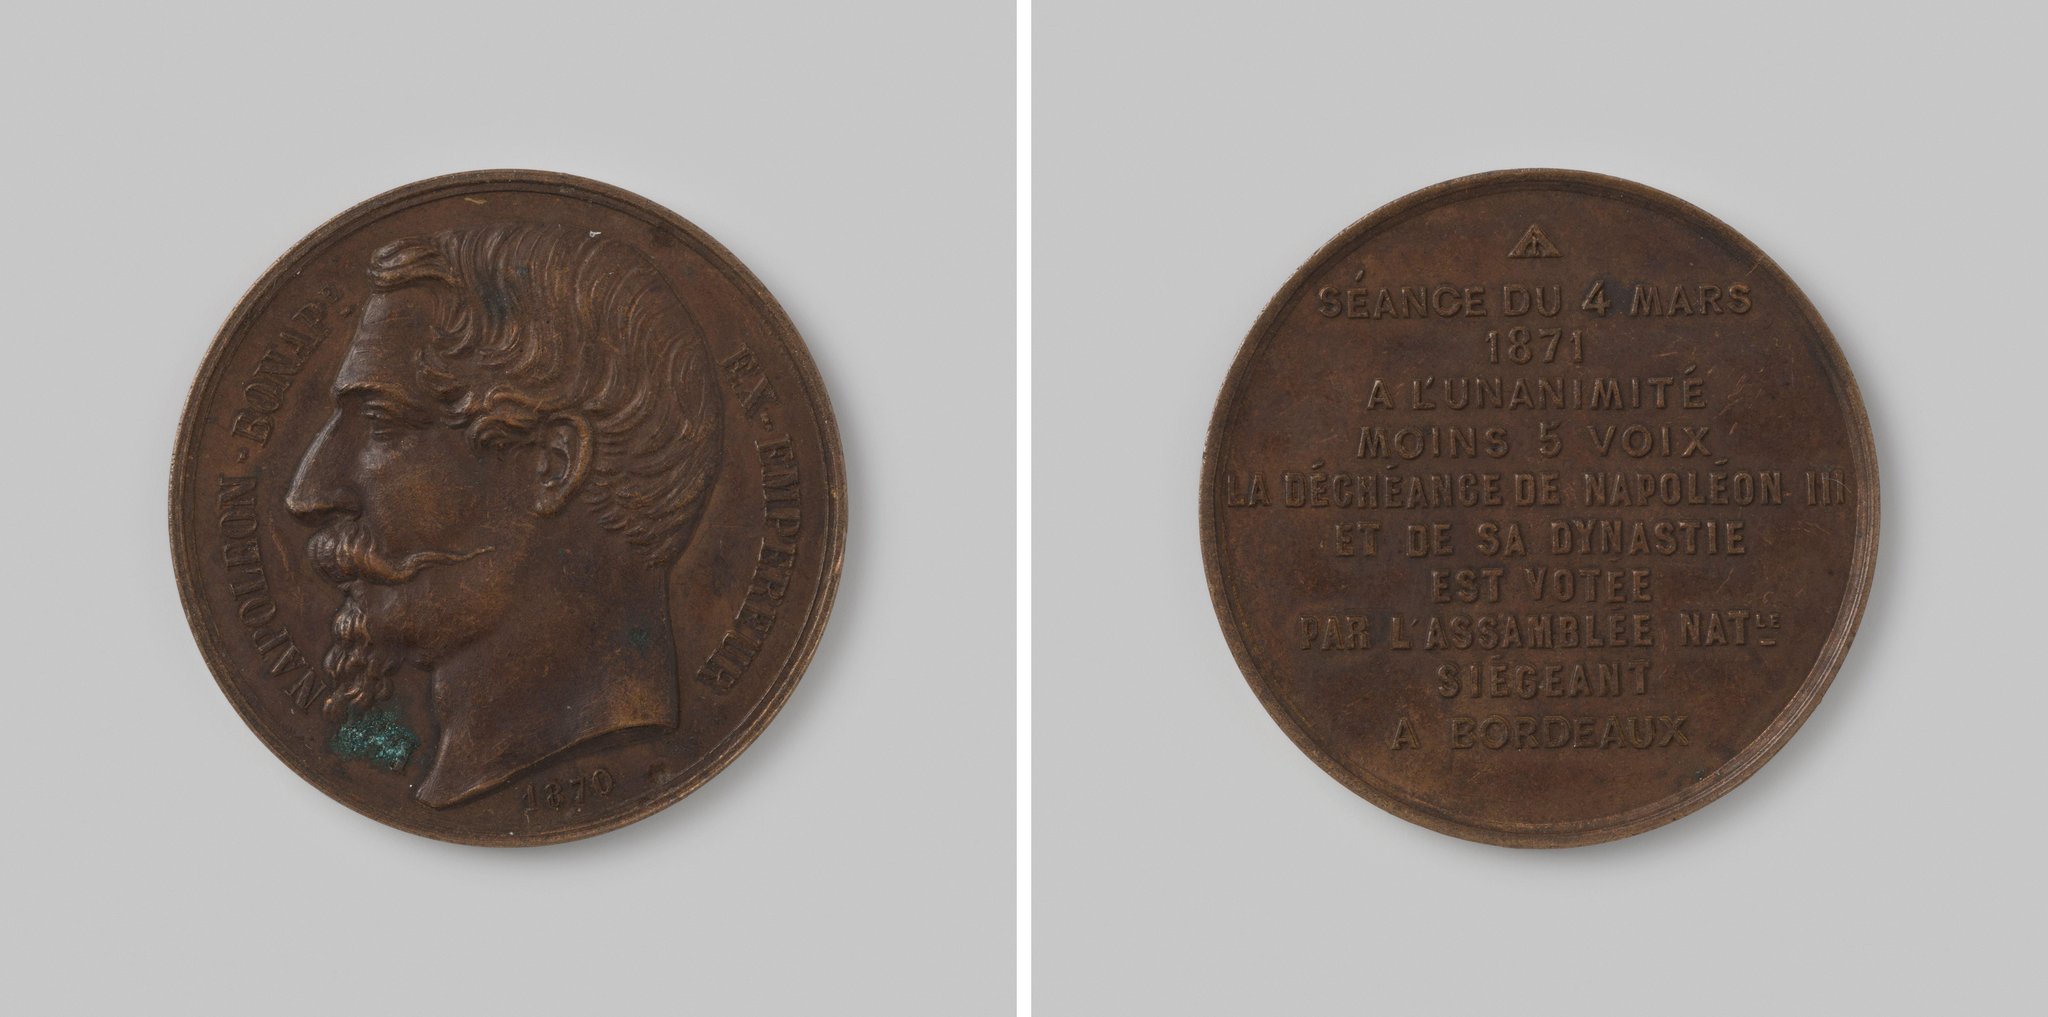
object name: history medal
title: Afzetting van Keizer Napoleon III en zijn dynastie 1871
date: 1871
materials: bronze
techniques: striking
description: Bronzen penning, op de voorzijde het portret van Napoleon naar links met omschrift, op de keerzijde elf regels tekst.